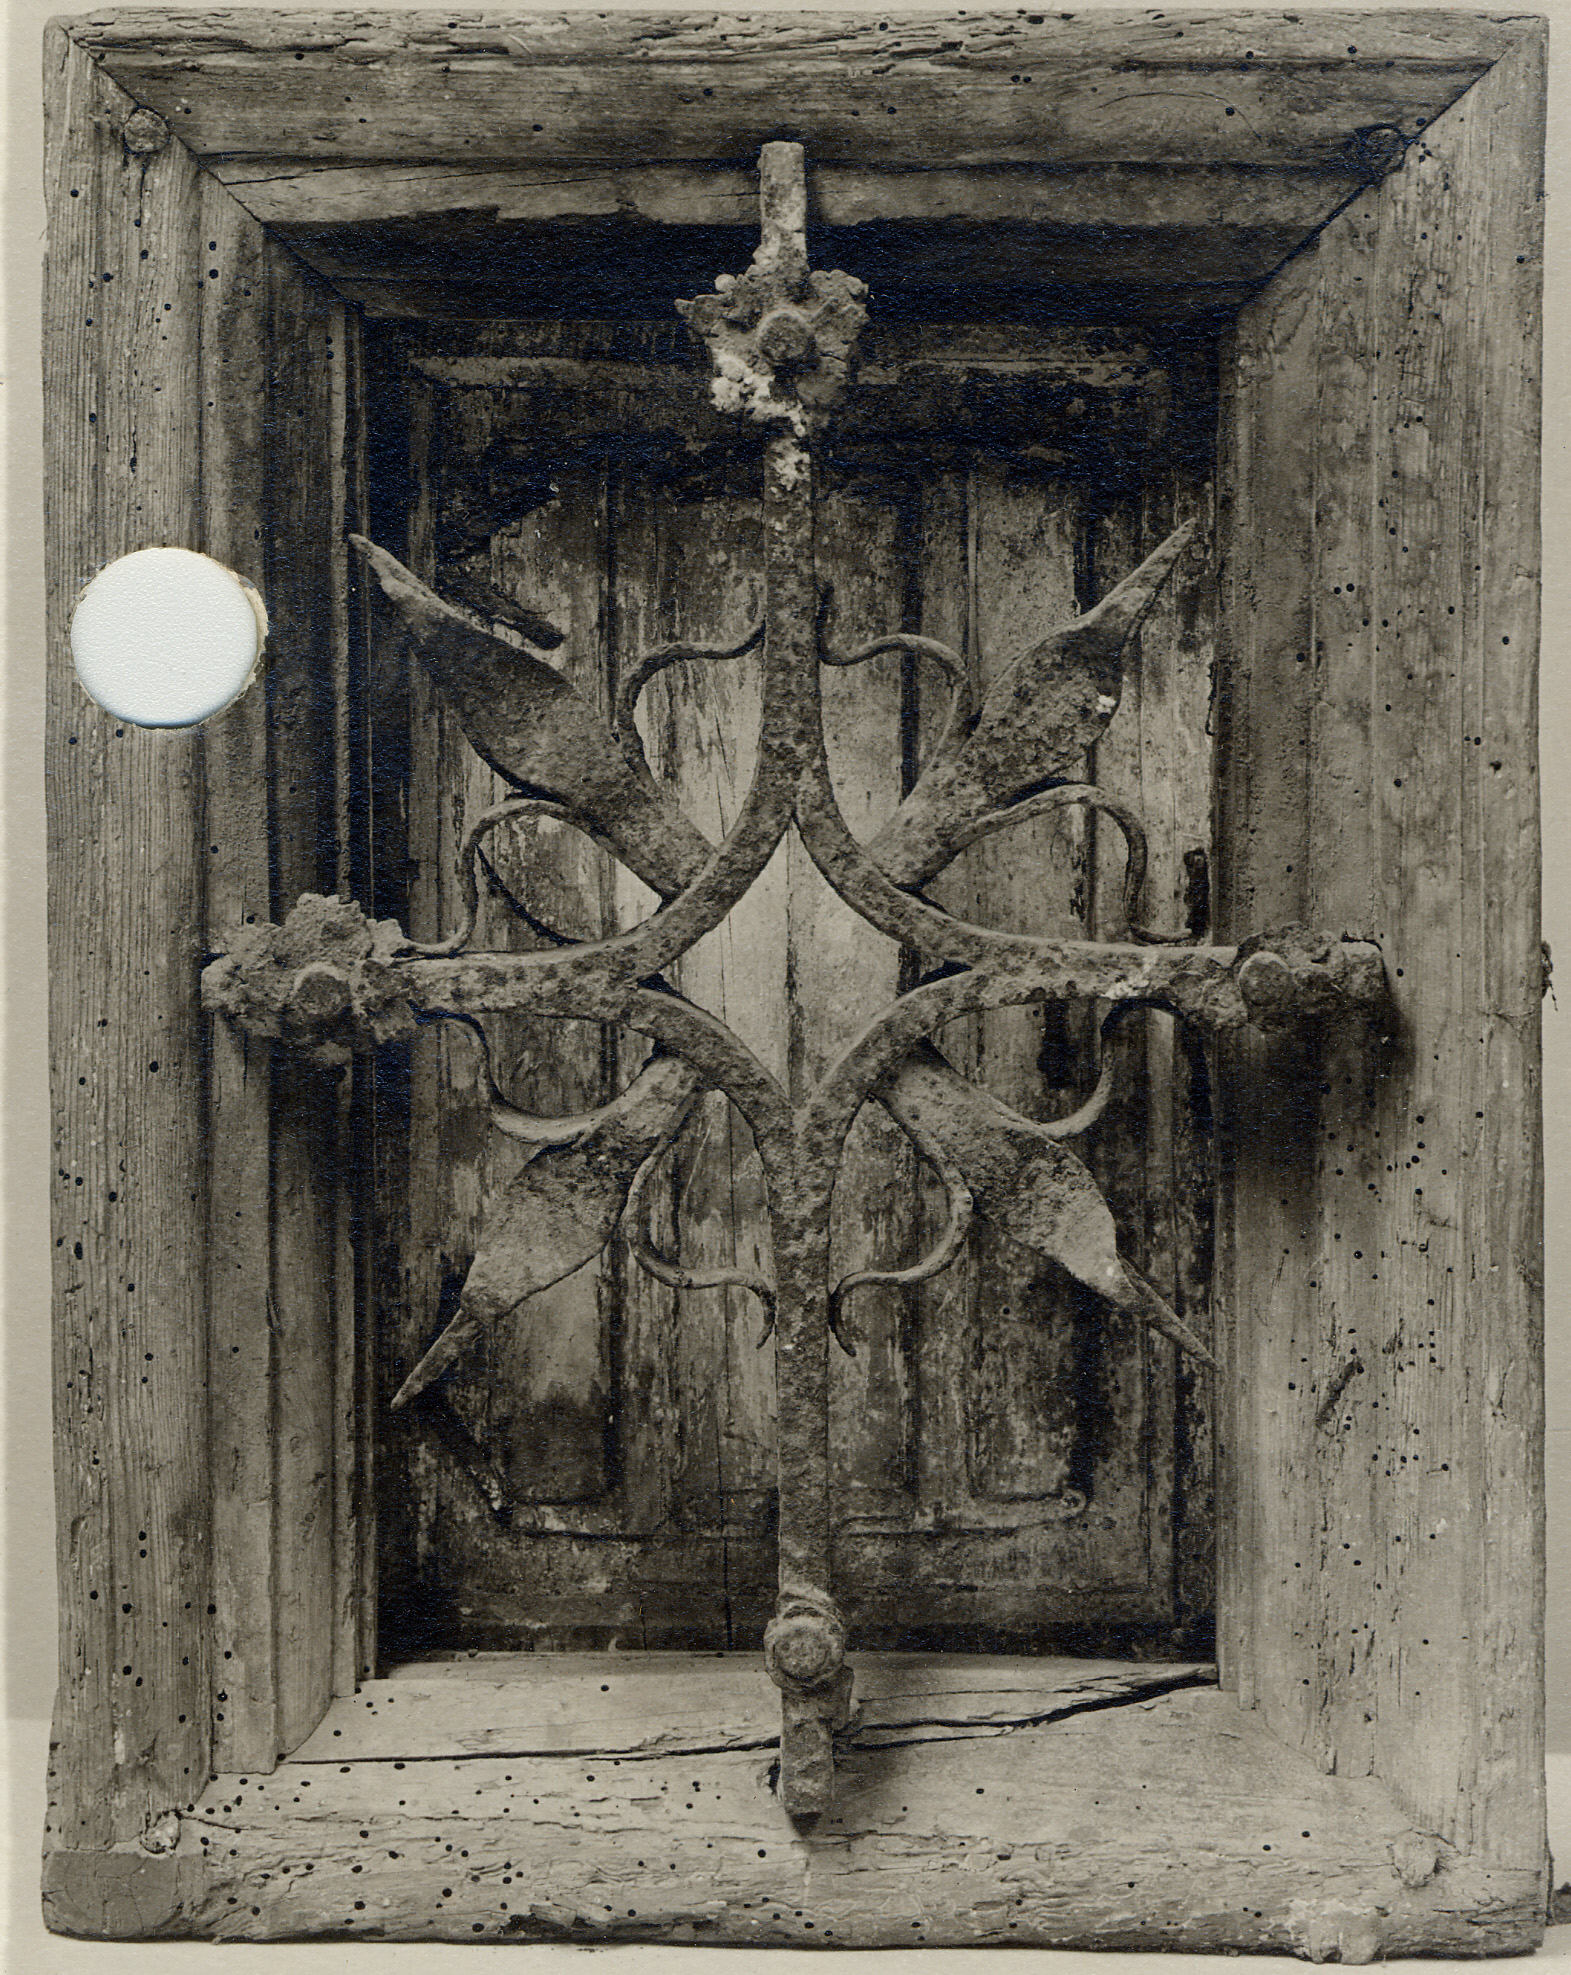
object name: window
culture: spanish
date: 1601-1700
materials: iron, wood